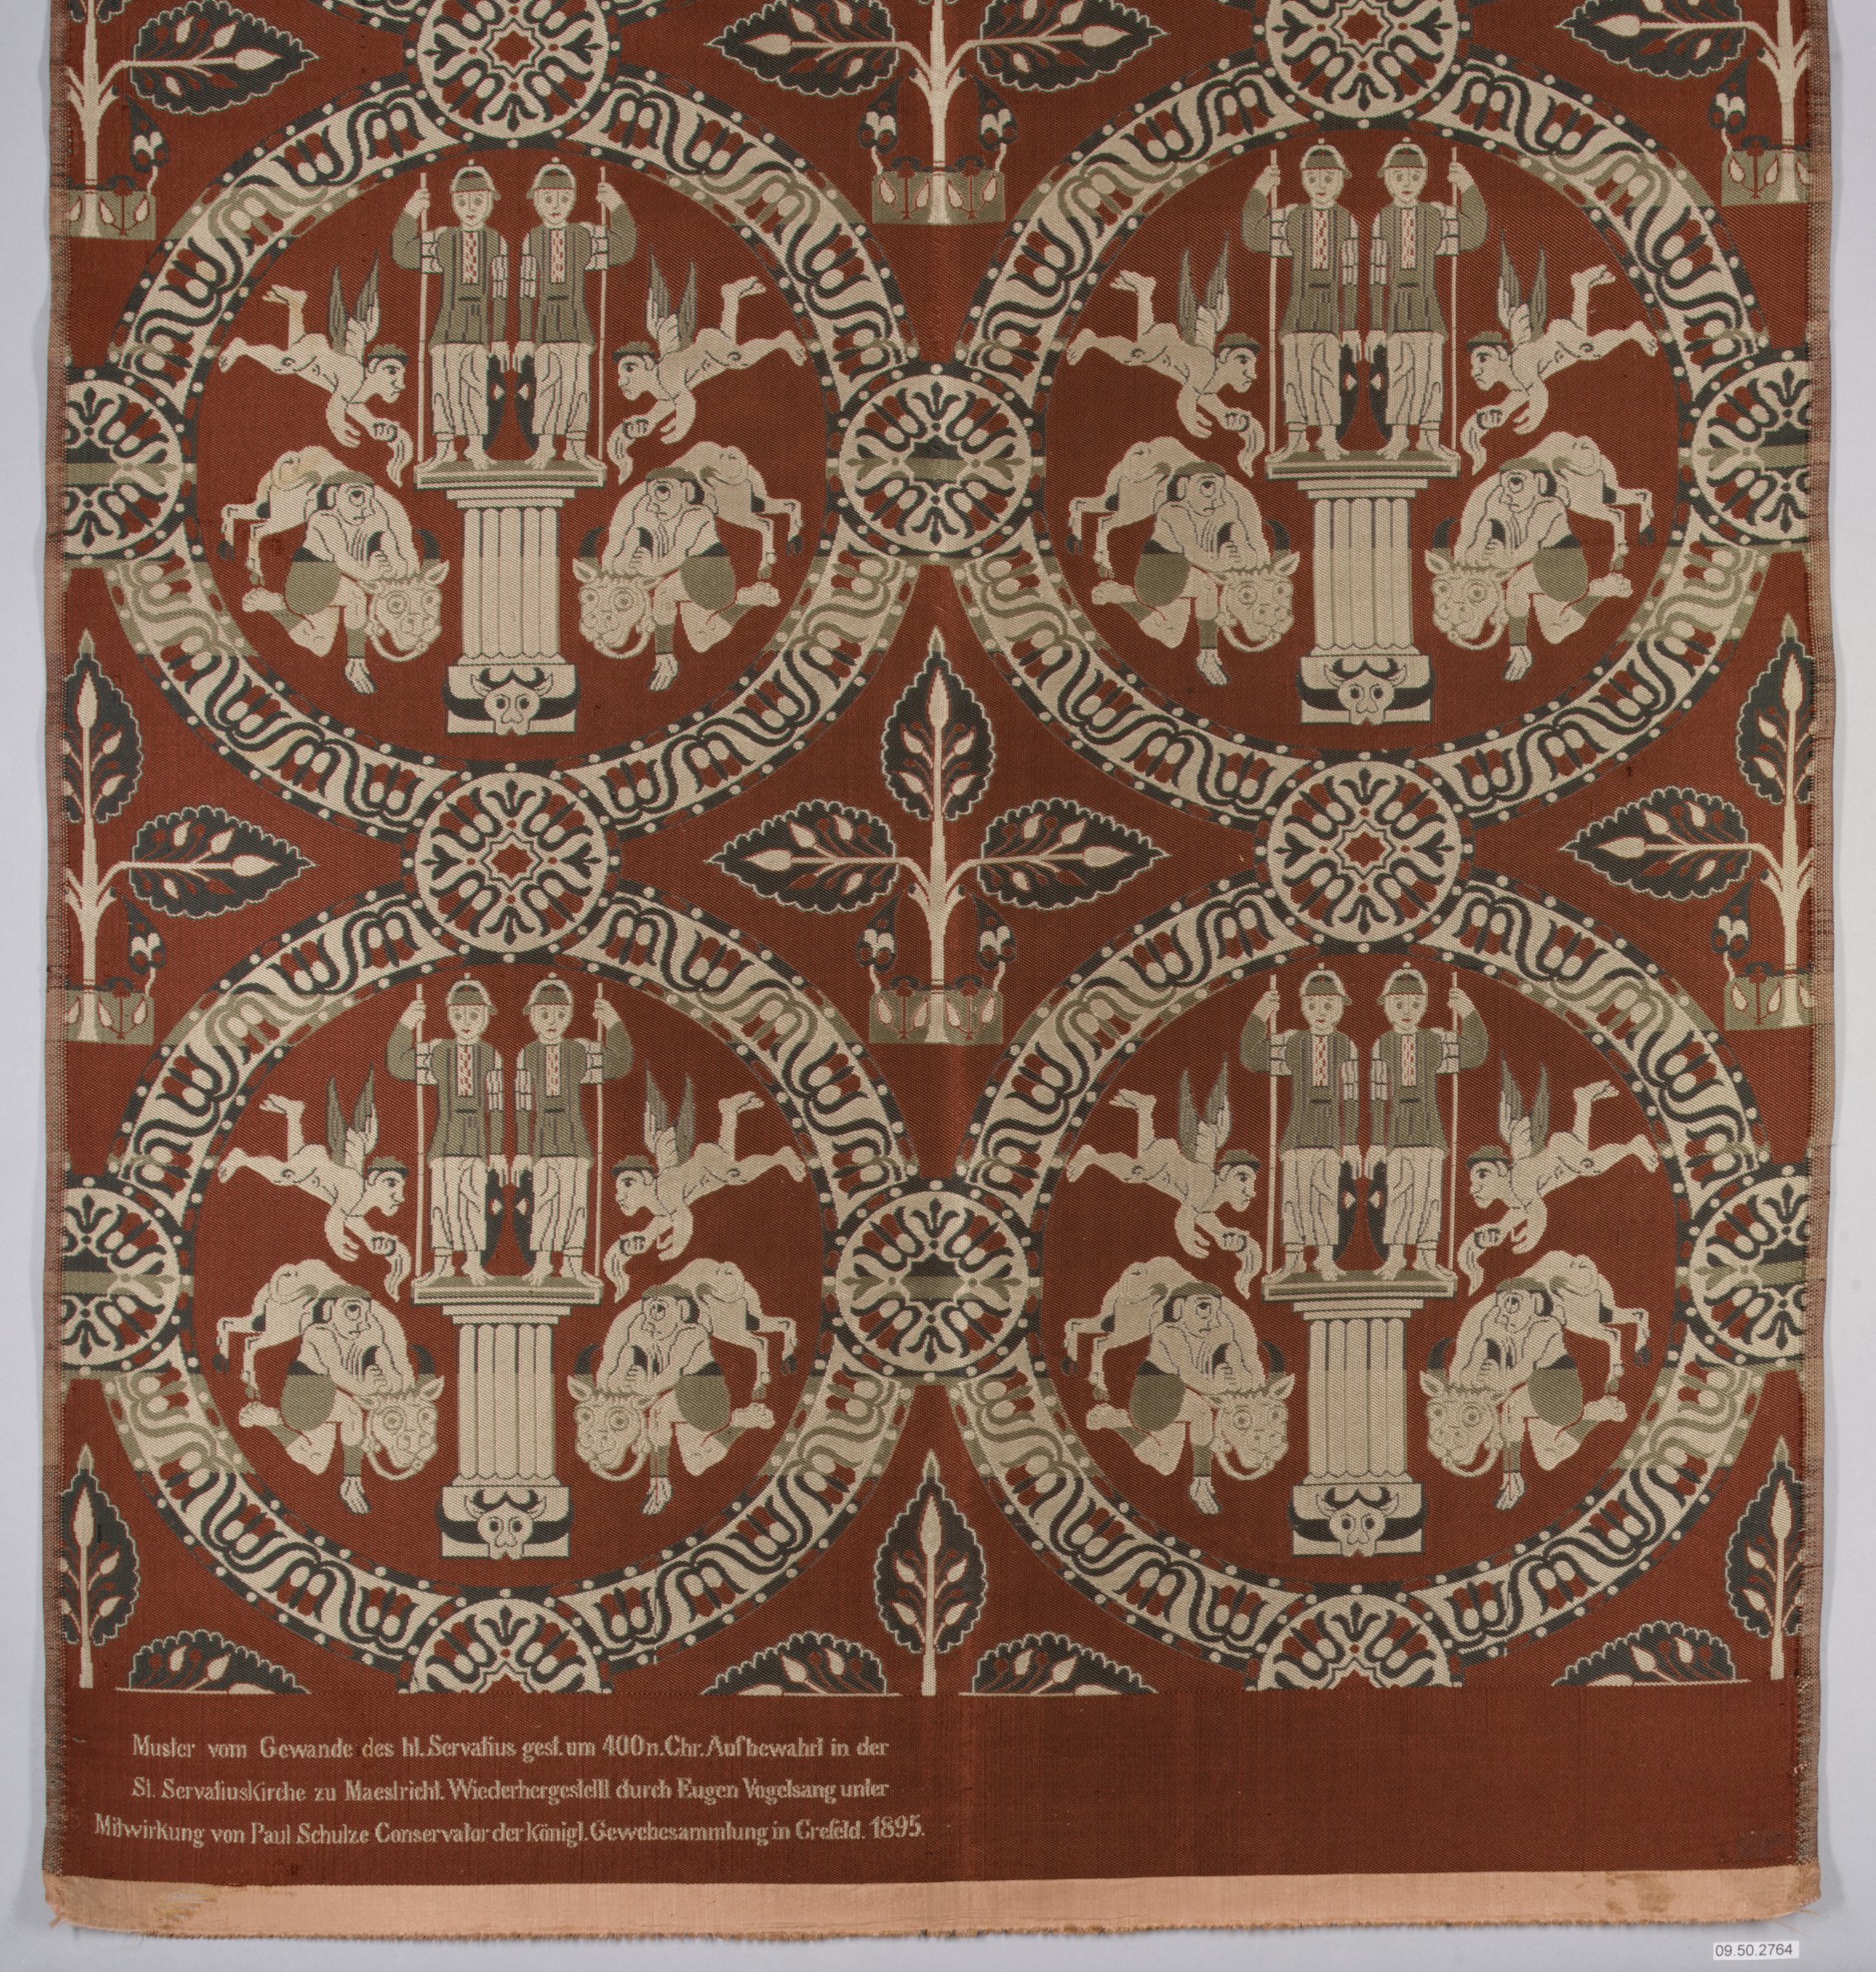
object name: textile fragment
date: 1801-1900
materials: silk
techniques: brocade, weave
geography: syria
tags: animals,men